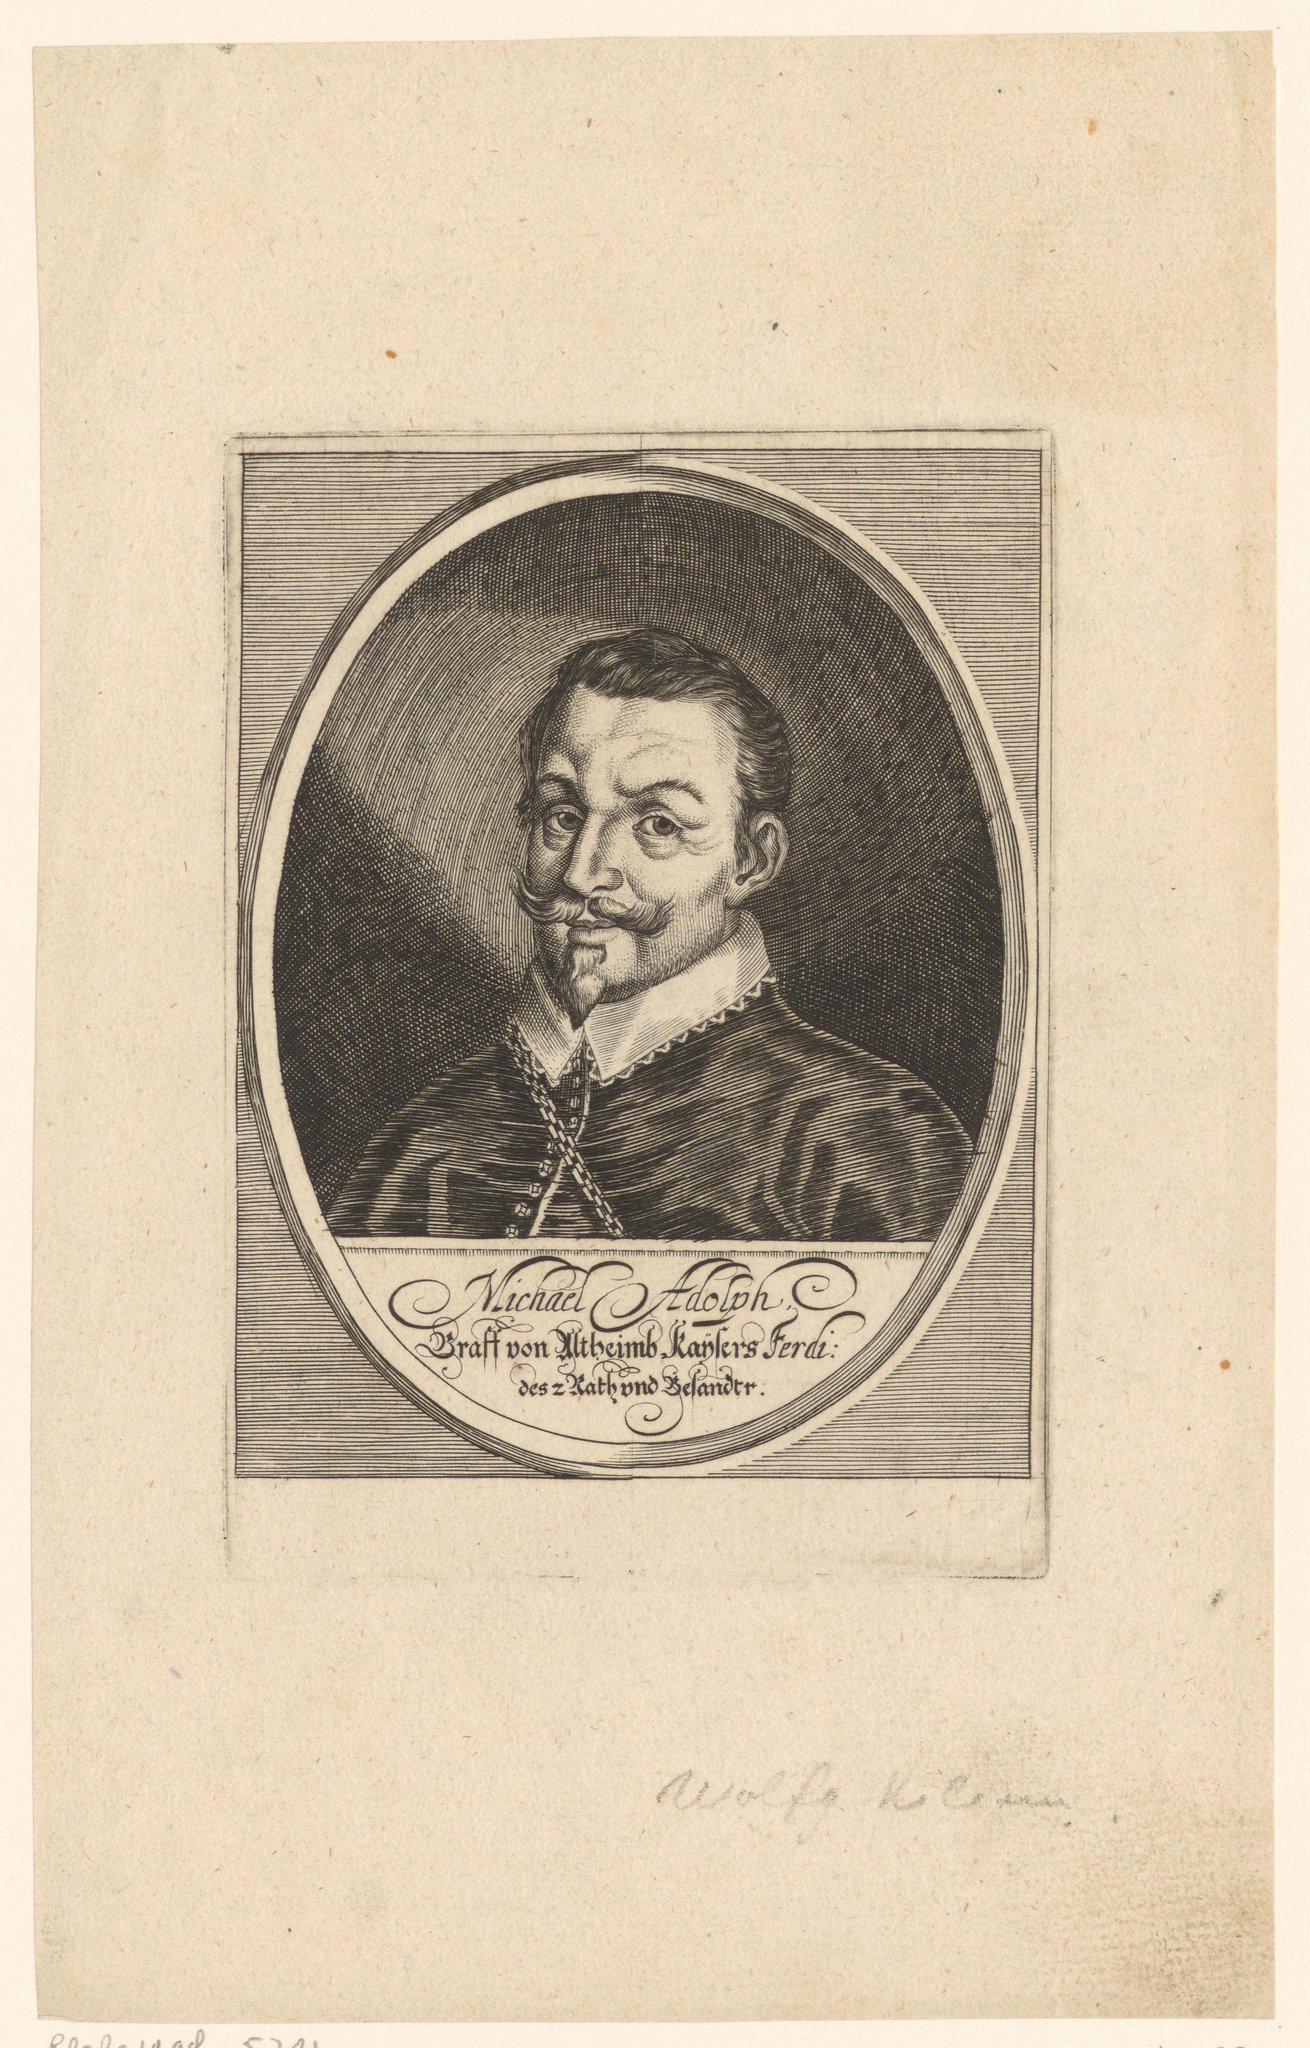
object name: print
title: Portret van Michael Adolf von Althann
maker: wolfgang kilian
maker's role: print maker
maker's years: 1581-1662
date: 1591-1662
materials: paper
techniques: engraving, etching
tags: vienna, earl, historical persons, officer, ambassador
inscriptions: collector's mark: Lugt 2228